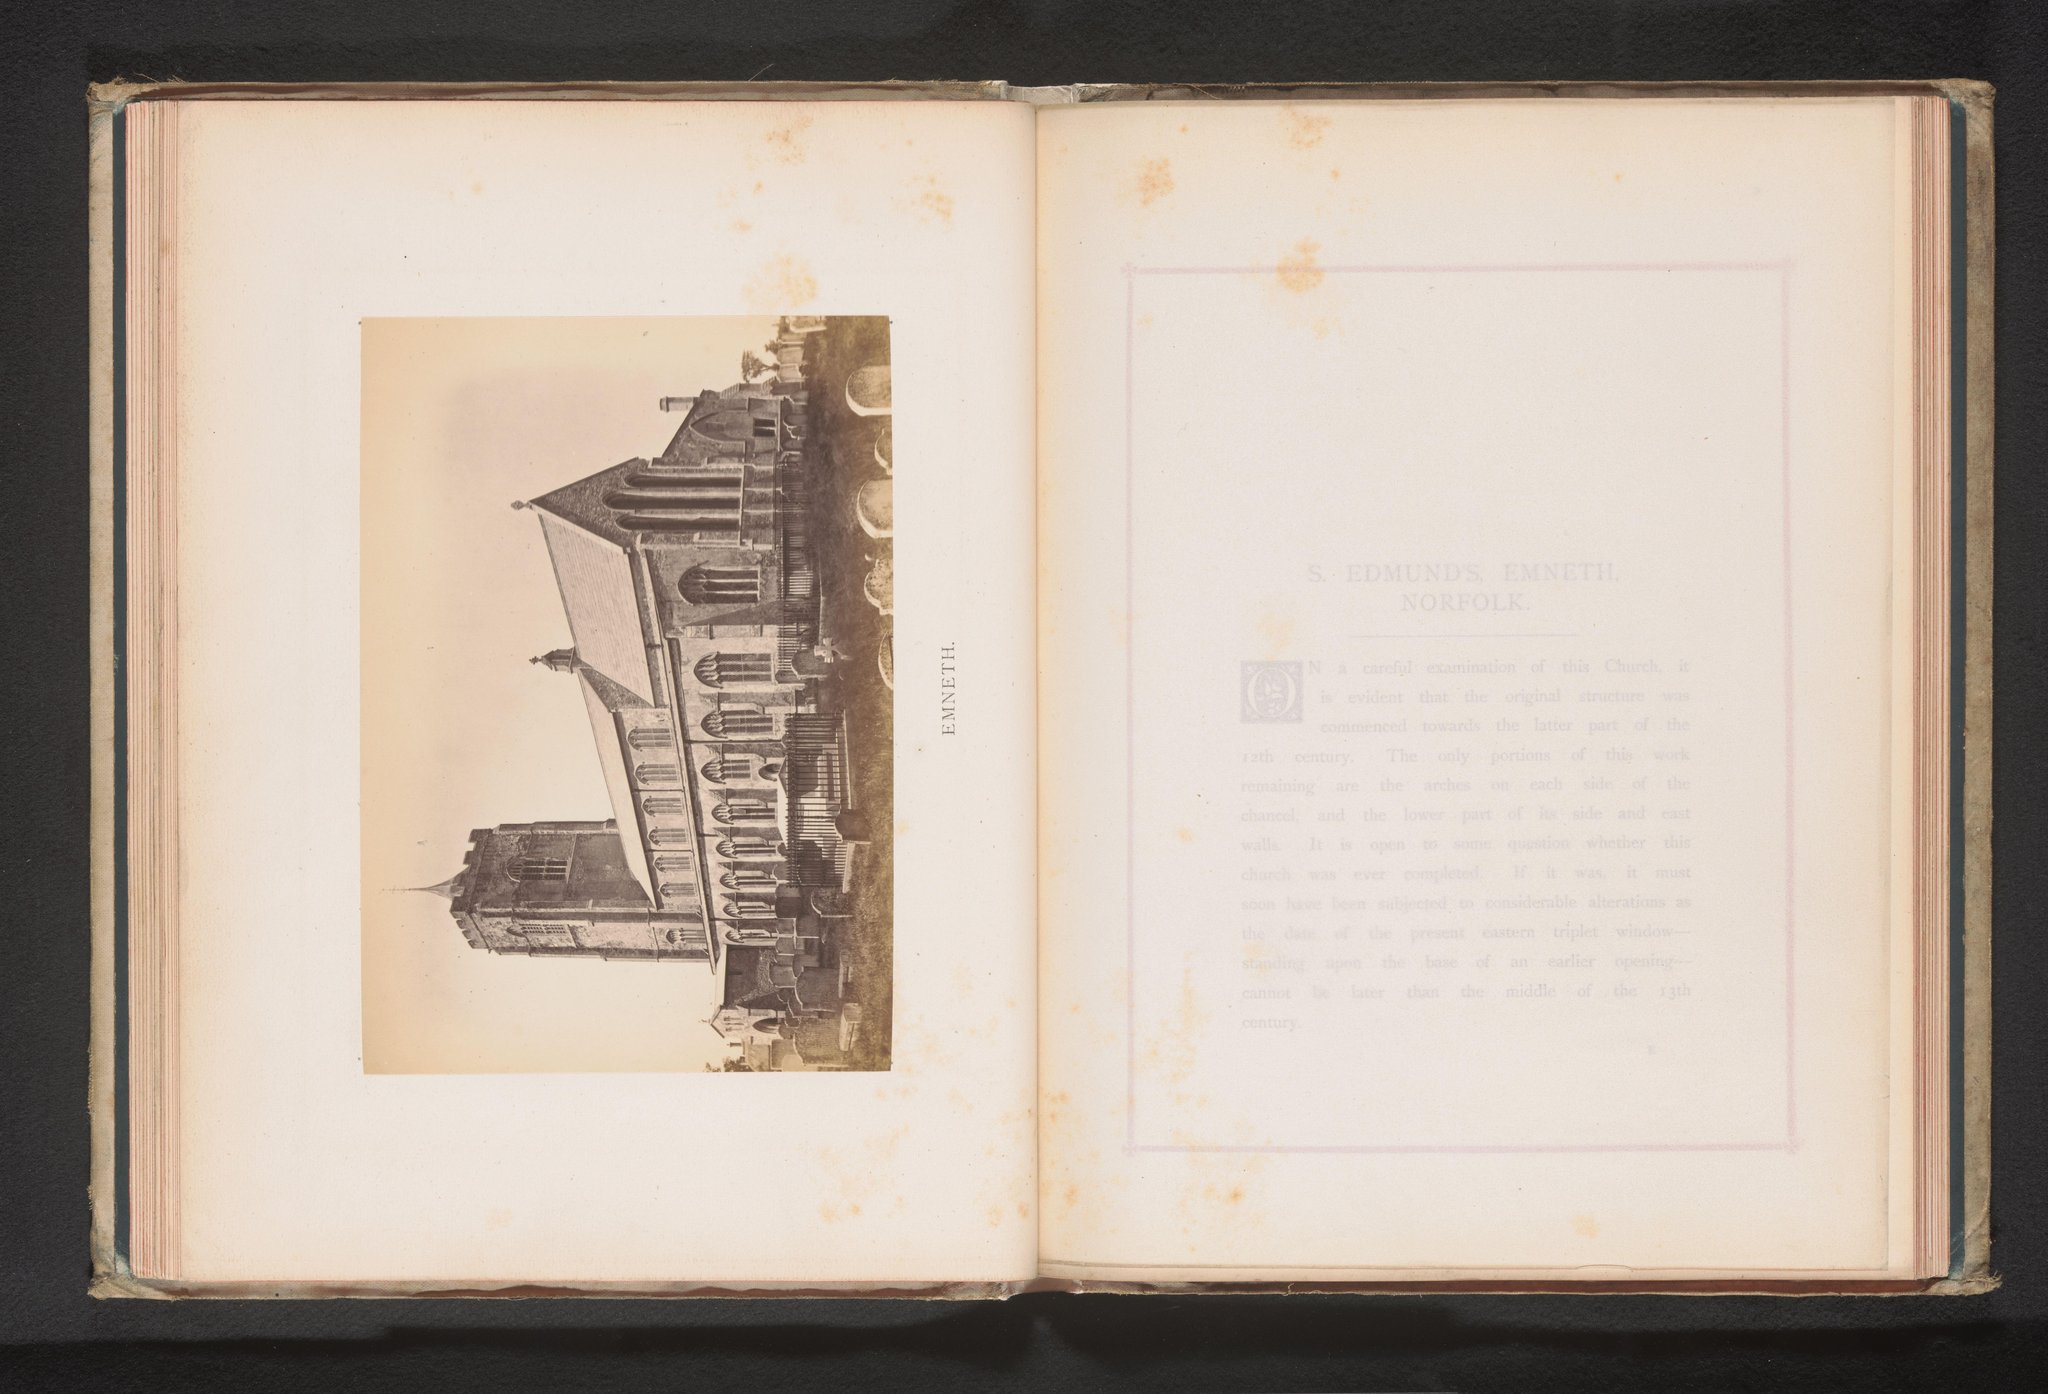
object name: page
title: Emneth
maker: edward johnson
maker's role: fotograaf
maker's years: 1822-1907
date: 1858-1869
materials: photographic support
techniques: albumen print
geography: emneth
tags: church (exterior), façade (of house or building), churchyard (around church)